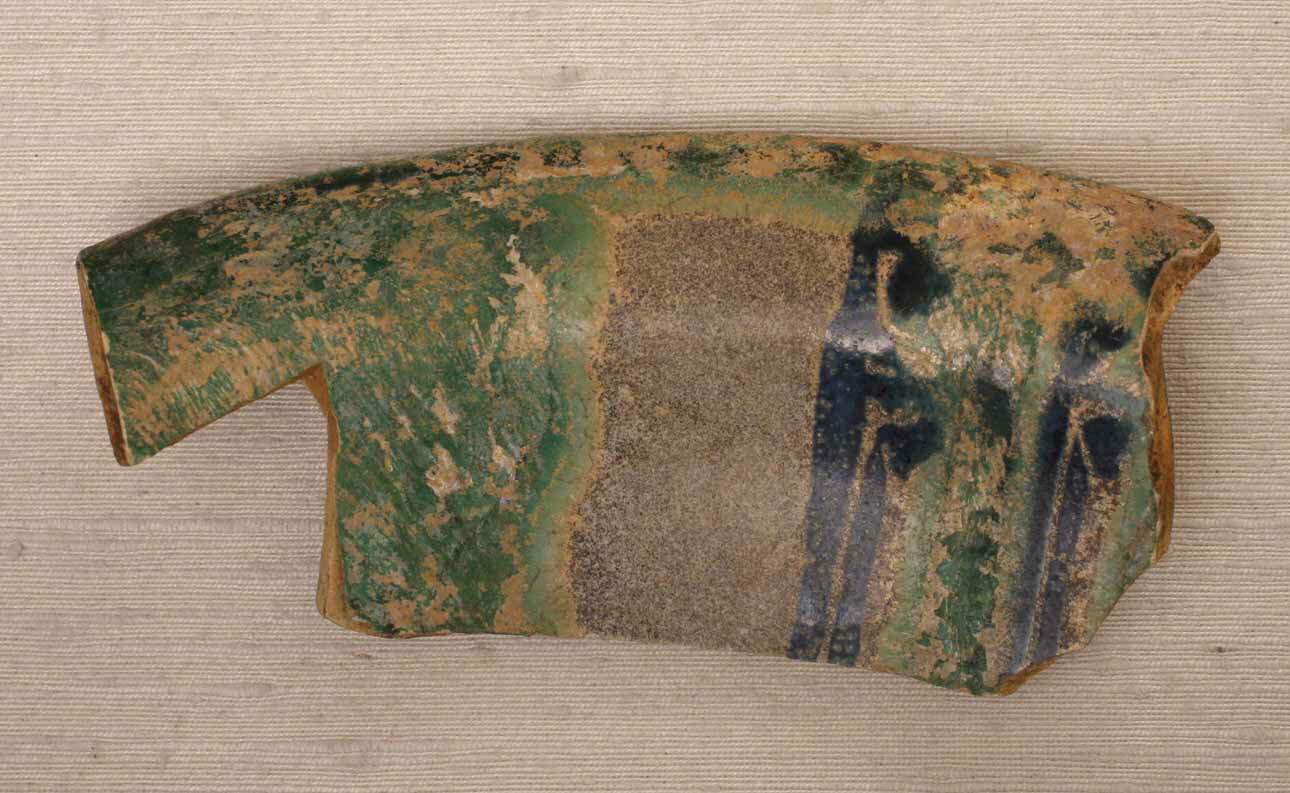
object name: fragment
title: Fragment of a Bowl with Green Splashes and Blue Painted Inscription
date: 801-900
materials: earthenware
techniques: glazing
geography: iraq